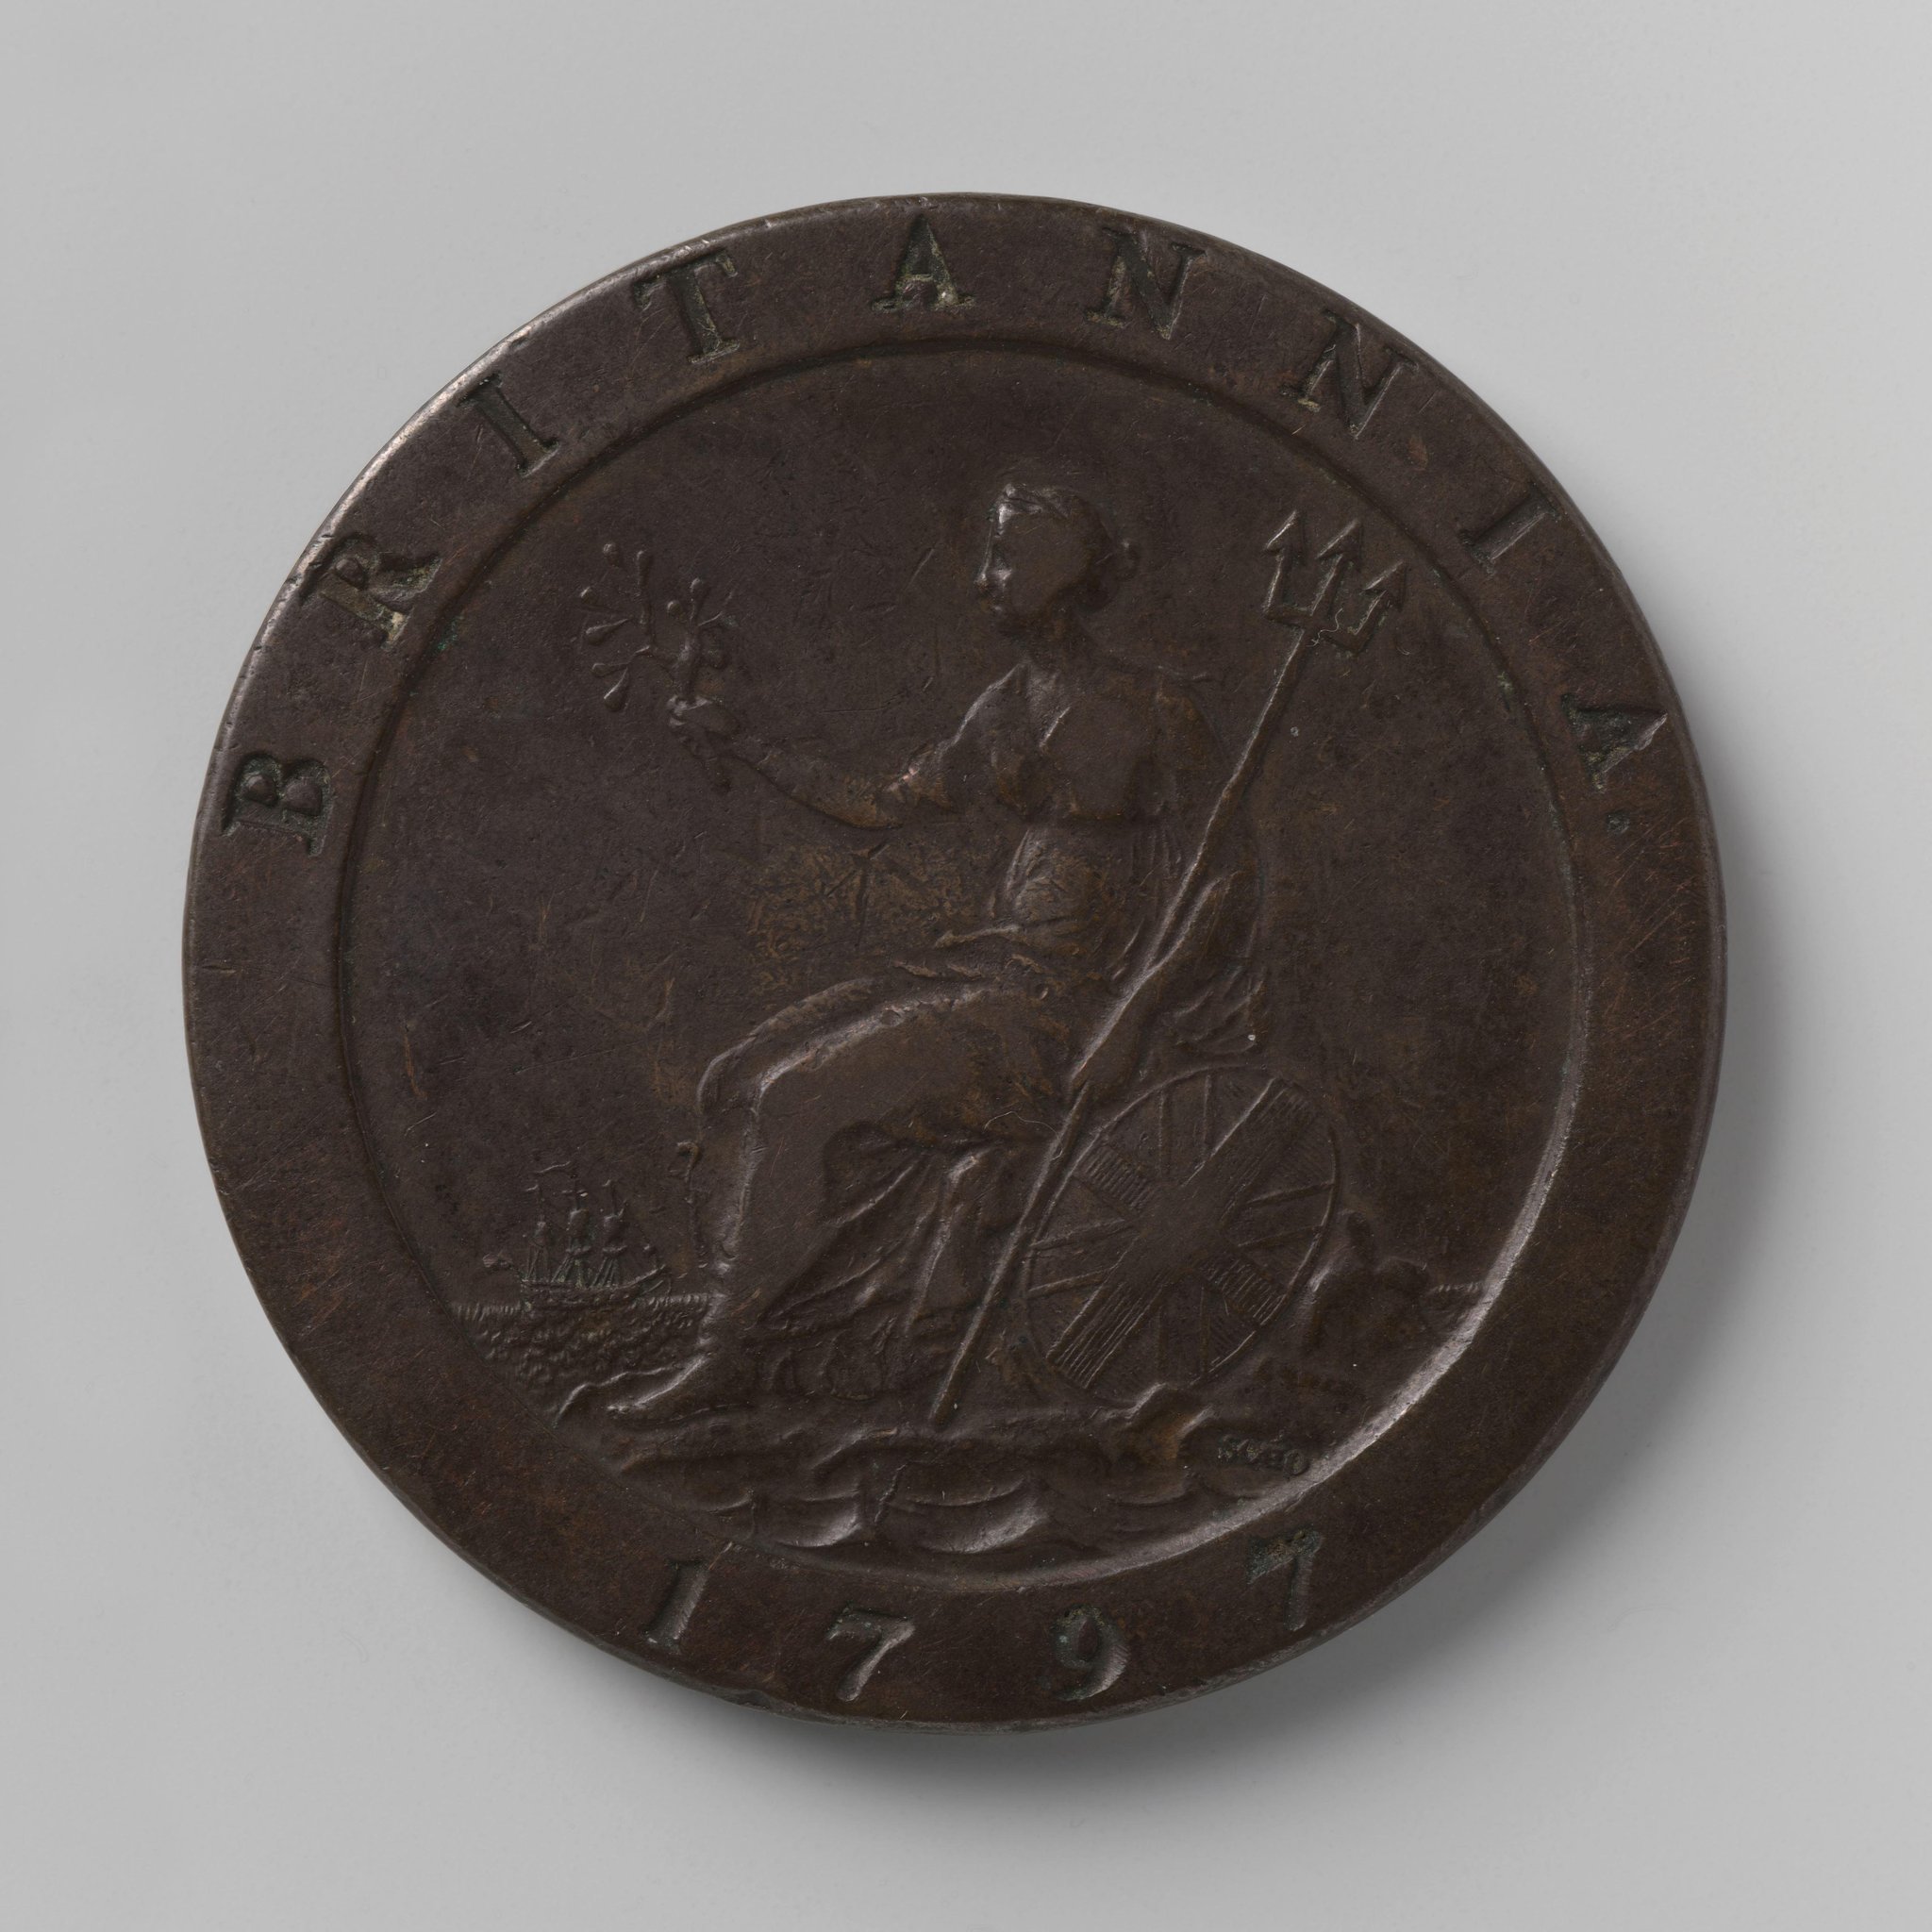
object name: coin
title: Engeland, George I, cartwheel-penny, 1797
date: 1719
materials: copper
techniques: striking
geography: birmingham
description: Koperen munt. Voorzijde: binnen brede rand met inwendig omschrift gelauwerd borstbeeld van de koning naar rechts. Keerzijde: binnen brede rand met inwendig omschrift, op in zee gelegen rots, waartegen schild geplaatst, gezeten Brittannia met drietand en tak, naar links. Links van haar schip. Jaartal in omschrift onderaan.